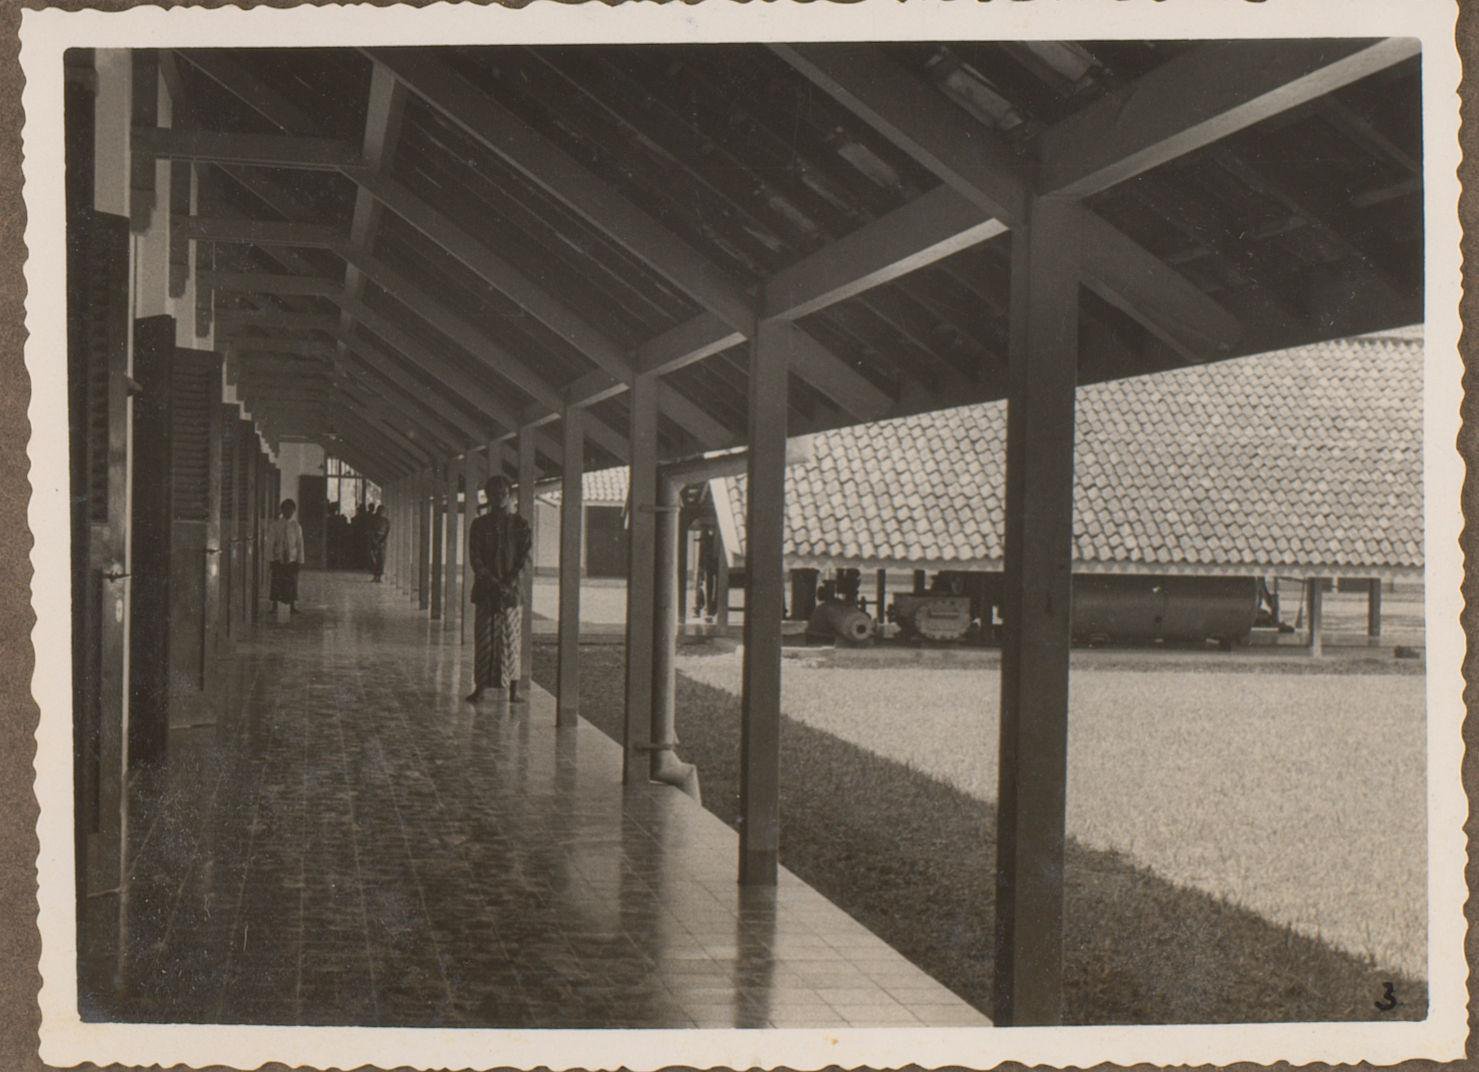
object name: photograph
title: Voorgevel van de Prinses Juliana School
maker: Anonymous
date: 1933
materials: photographic support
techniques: gelatin silver print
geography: jogjakarta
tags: vocational education, e.g.: junior technical school (+ building ~ education, tuition), colonial government, dutch east indies, the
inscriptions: inscription: ‘Voorgevel / PJS’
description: Voorgevel van de Prinses Juliana School te Jogyakarta. Panorama opgebouwd uit zes aan elkaar geplakte foto's en delen van foto's, in een openslaand mapje. Foto ingeplakt in het fotoalbum aangeboden aan J.H.A. van der Hoeven bij het beëindigen op 31 juli 1933 van zijn diensttijd bij het Nijverheidsonderwijs in Nederlandsch-Indië.